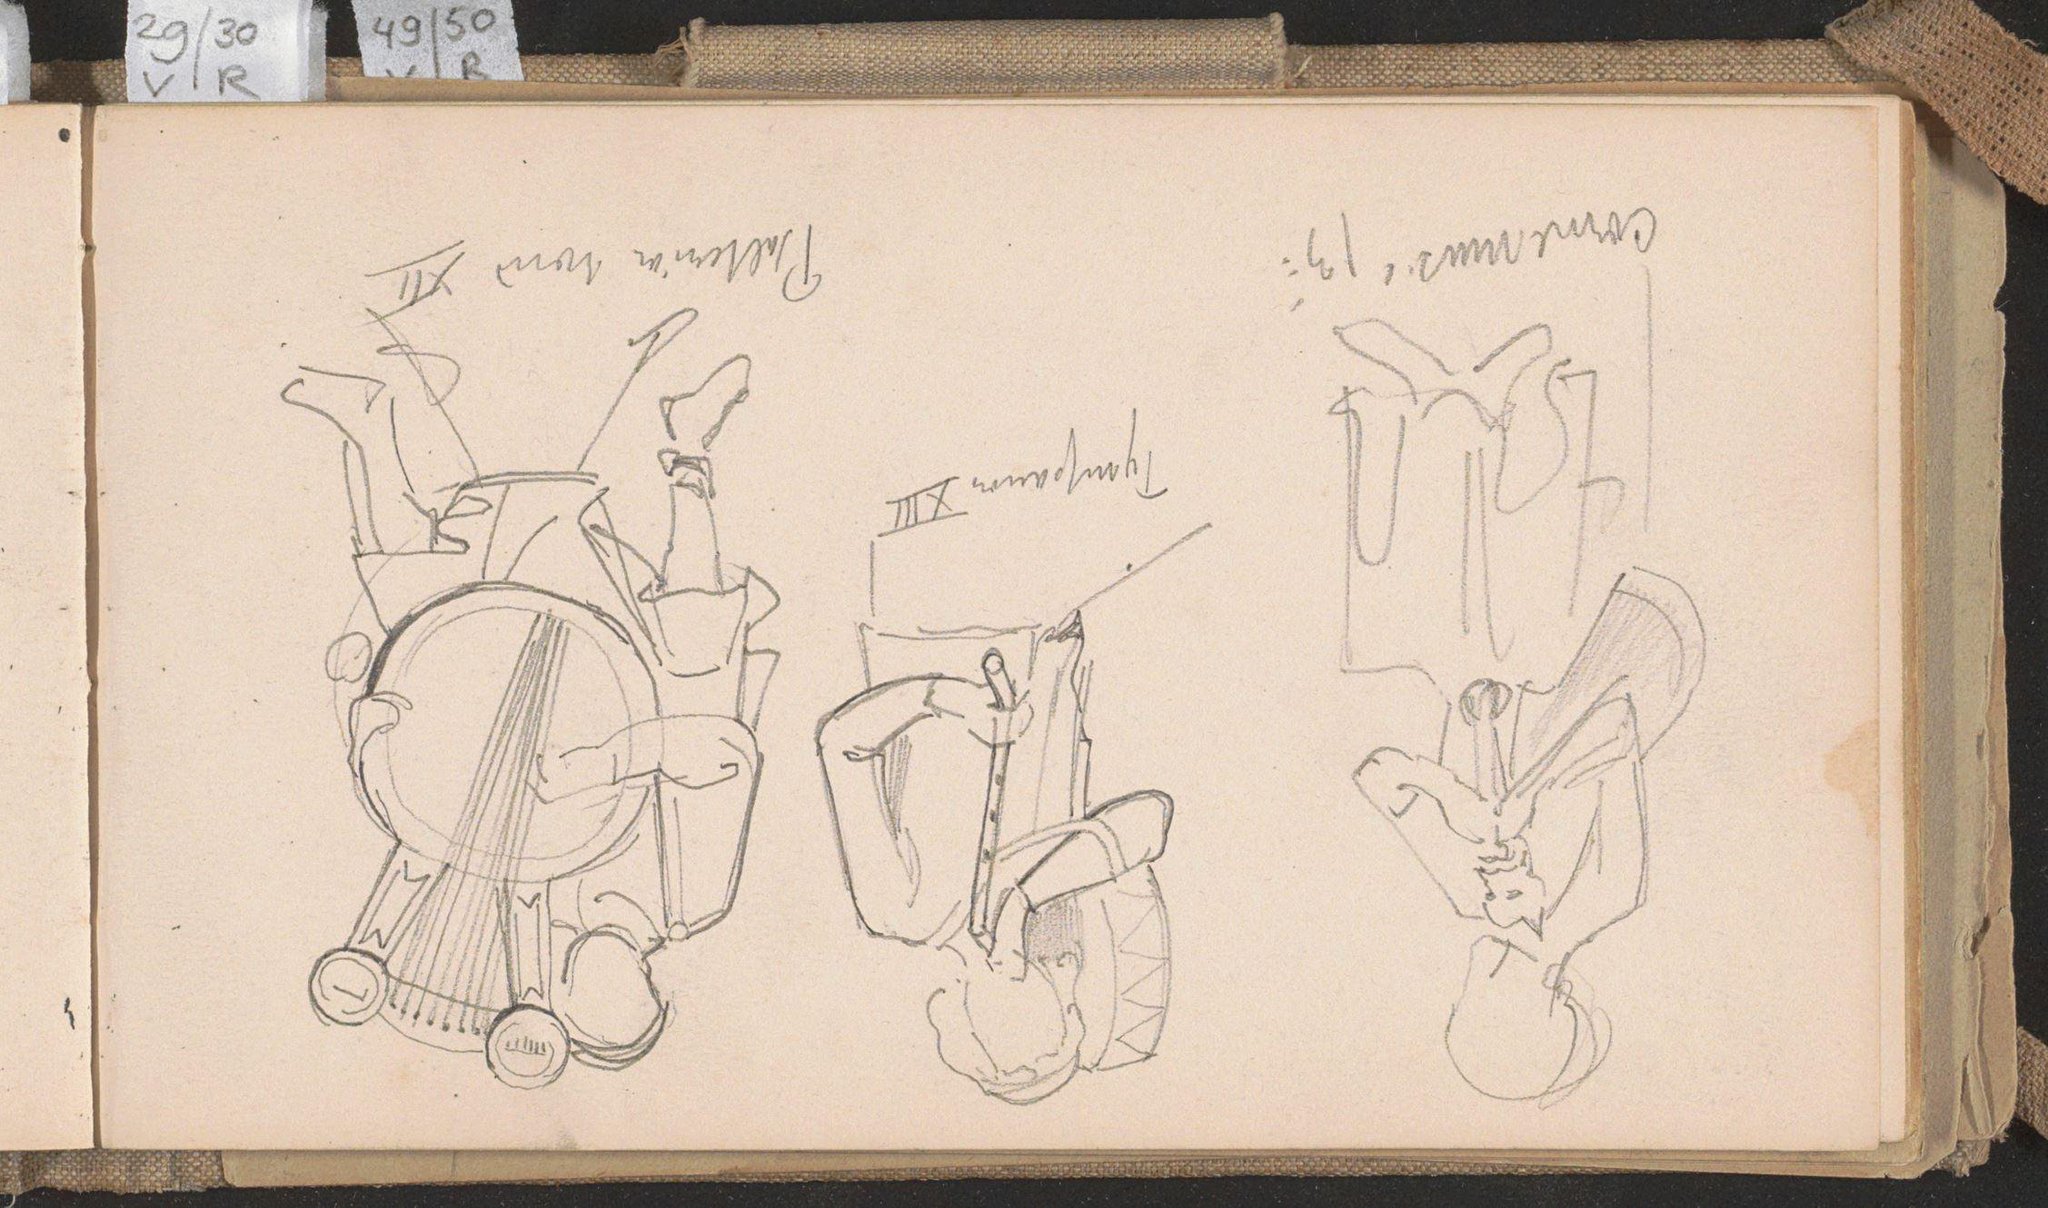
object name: sketchbook leaf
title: Figuren die een cornemuse, tympanon en psalterium bespelen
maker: antoon derkinderen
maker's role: draughtsman, painter, print maker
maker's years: 1859-1925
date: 1892-1901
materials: paper, pencil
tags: percussion instruments, bagpipe, musette, string instruments (plucked)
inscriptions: annotation: ‘cornemuse 13-/ Tympanon XIII/ Psalteria rond XII’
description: Getekend naar voorbeelden uit de twaalfde en dertiende eeuw na Christus. Blad 26 recto uit een schetsboek met 51 bladen.